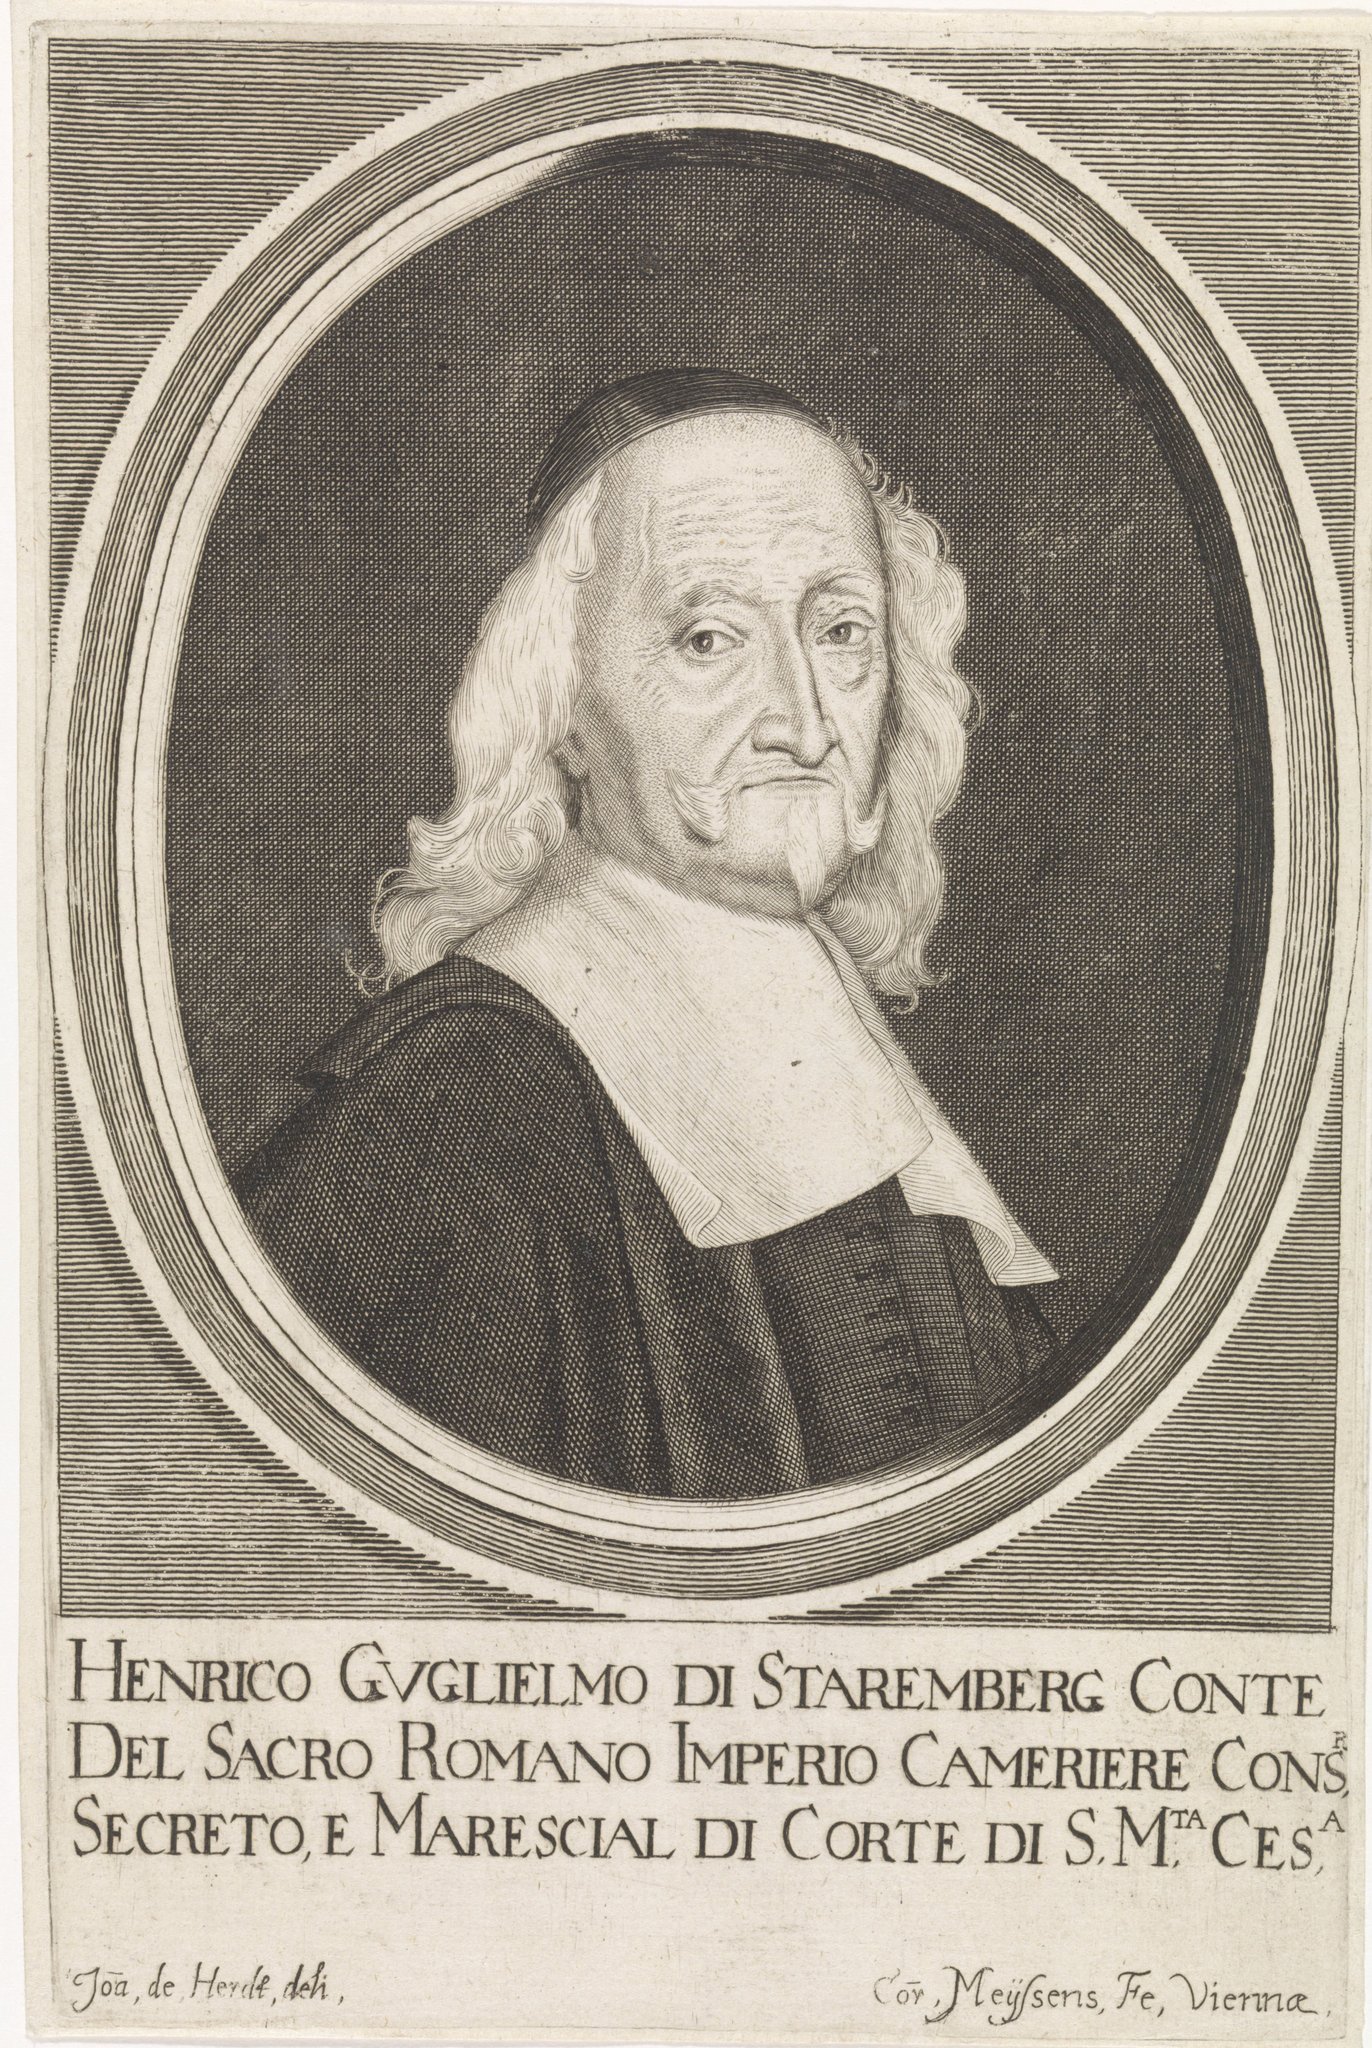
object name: print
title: Portret van Hendrik Willem van Starhemberg-Schaunberg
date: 1670-1674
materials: paper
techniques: engraving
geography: vienna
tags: vienna, earl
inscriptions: collector's mark: Lugt 2228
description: Prent mogelijk gebruikt in: Gualdo Priorato, Galeazzo. Historia di Leopoldo Cesare, (...). 3 dln. Wenen, Giovanni Battista Hacque, 1670-1674.